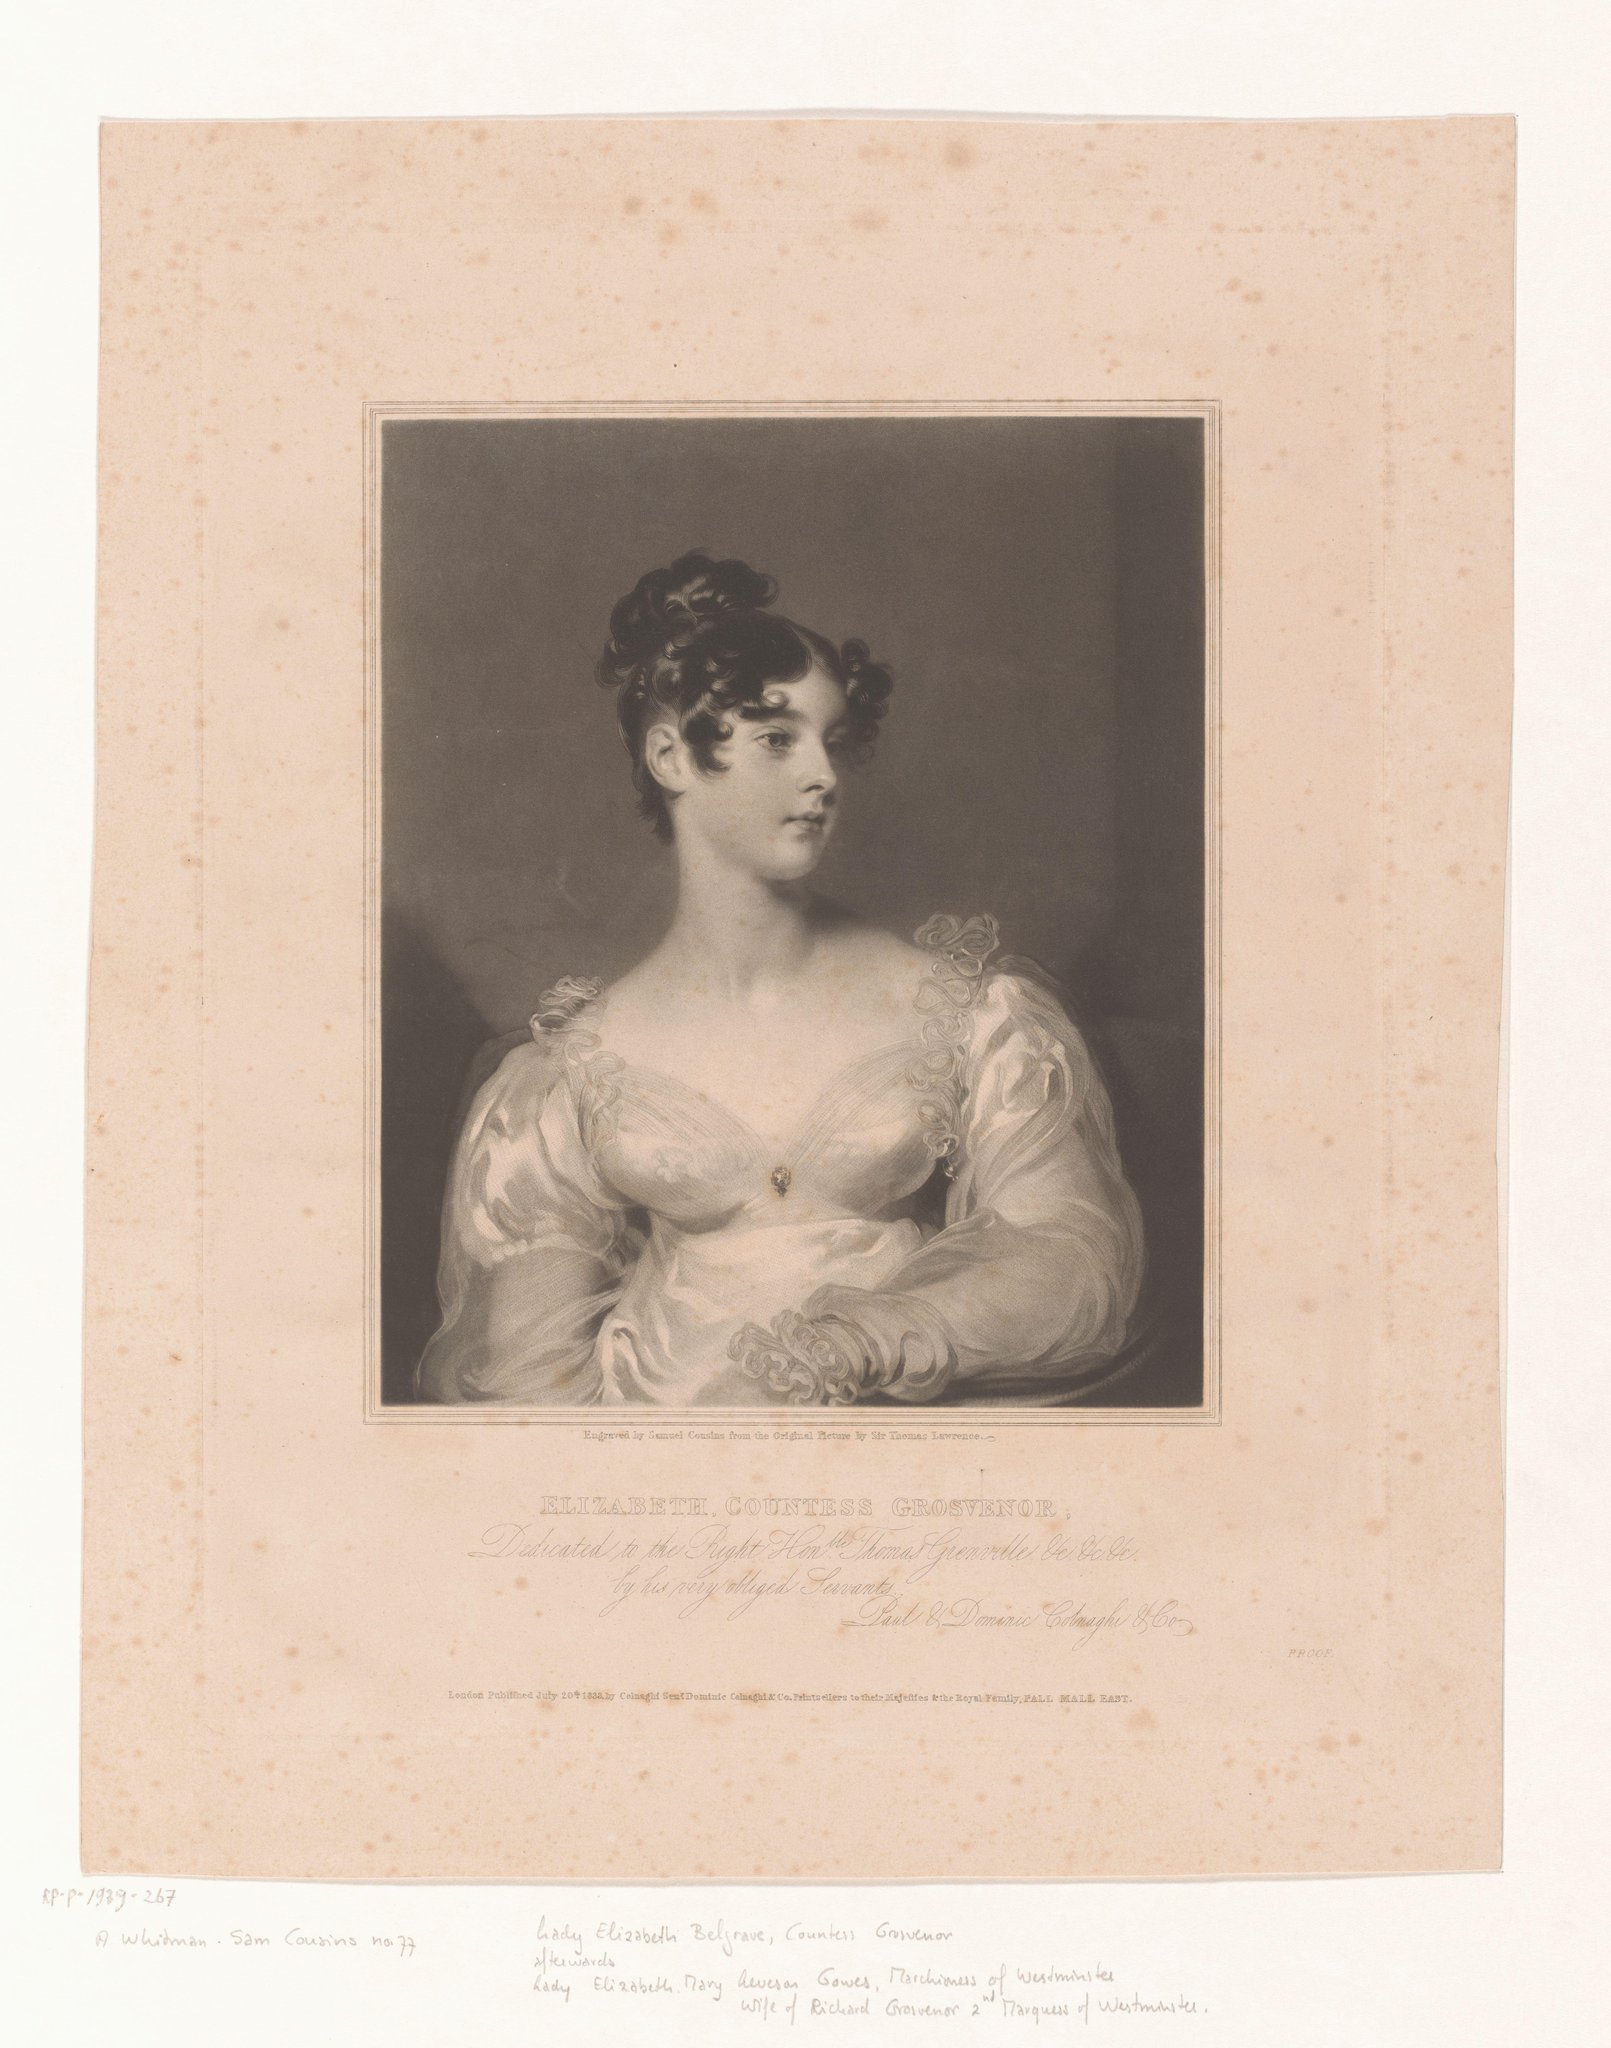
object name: print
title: Portret van Elizabeth Leveson-Gower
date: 1833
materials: paper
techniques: etching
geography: london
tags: historical persons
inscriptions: collector's mark: Lugt 2228, collector's mark: Lugt 2760, collector's mark: Lugt 2760